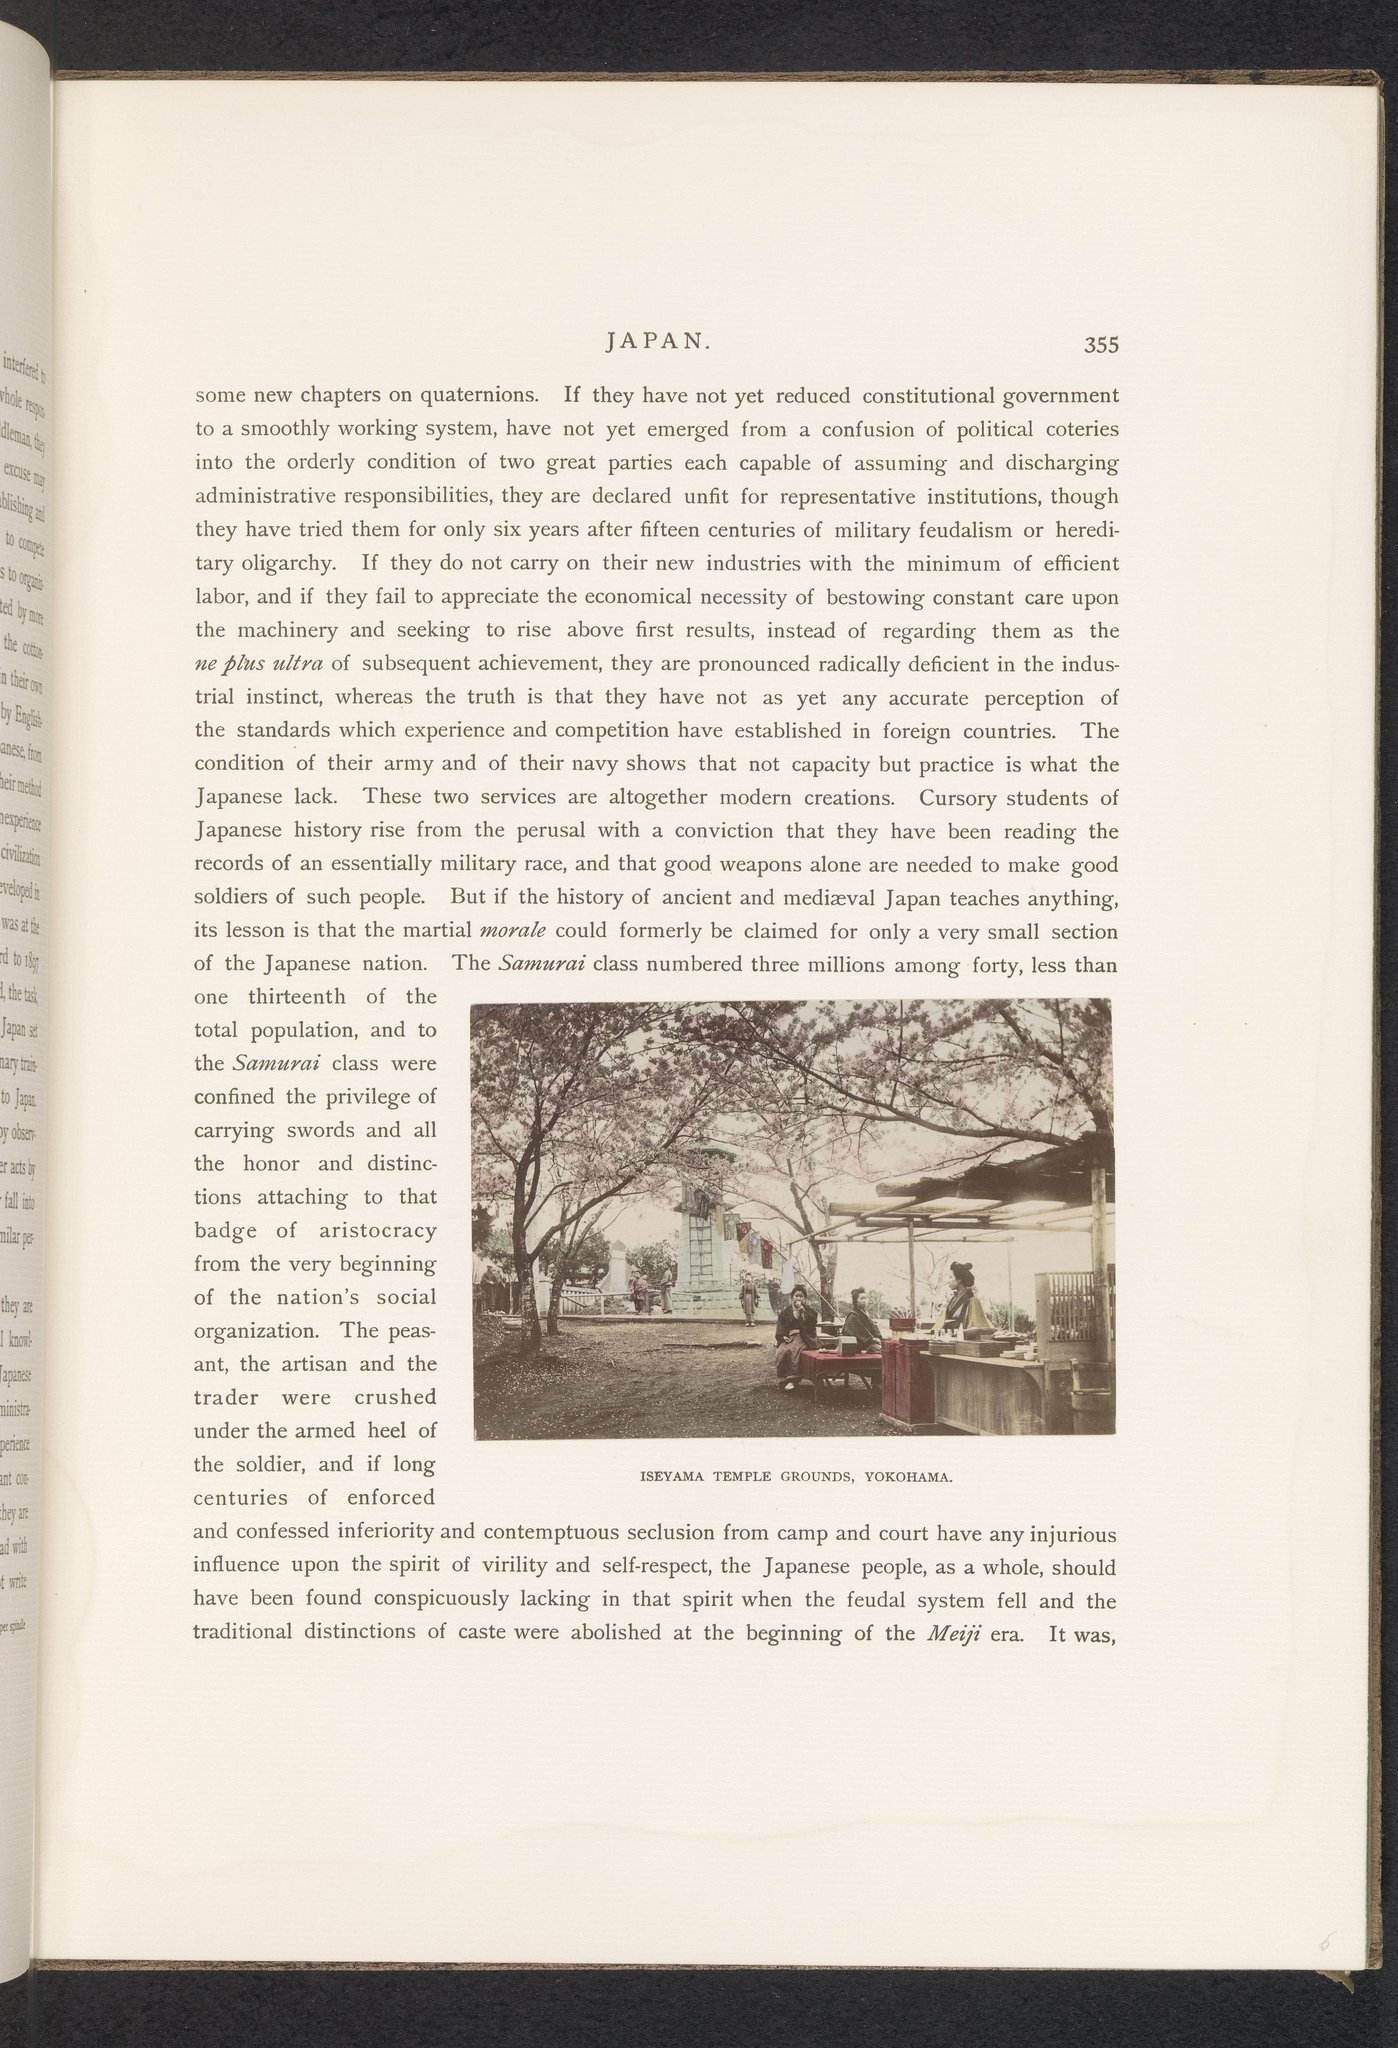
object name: photograph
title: Iseyama temple grounds, Yokohama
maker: Anonymous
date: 1888-1898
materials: photographic support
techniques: albumen print, hand coloring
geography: japan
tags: temple, shrine ~ non-christian religions, public gardens, park